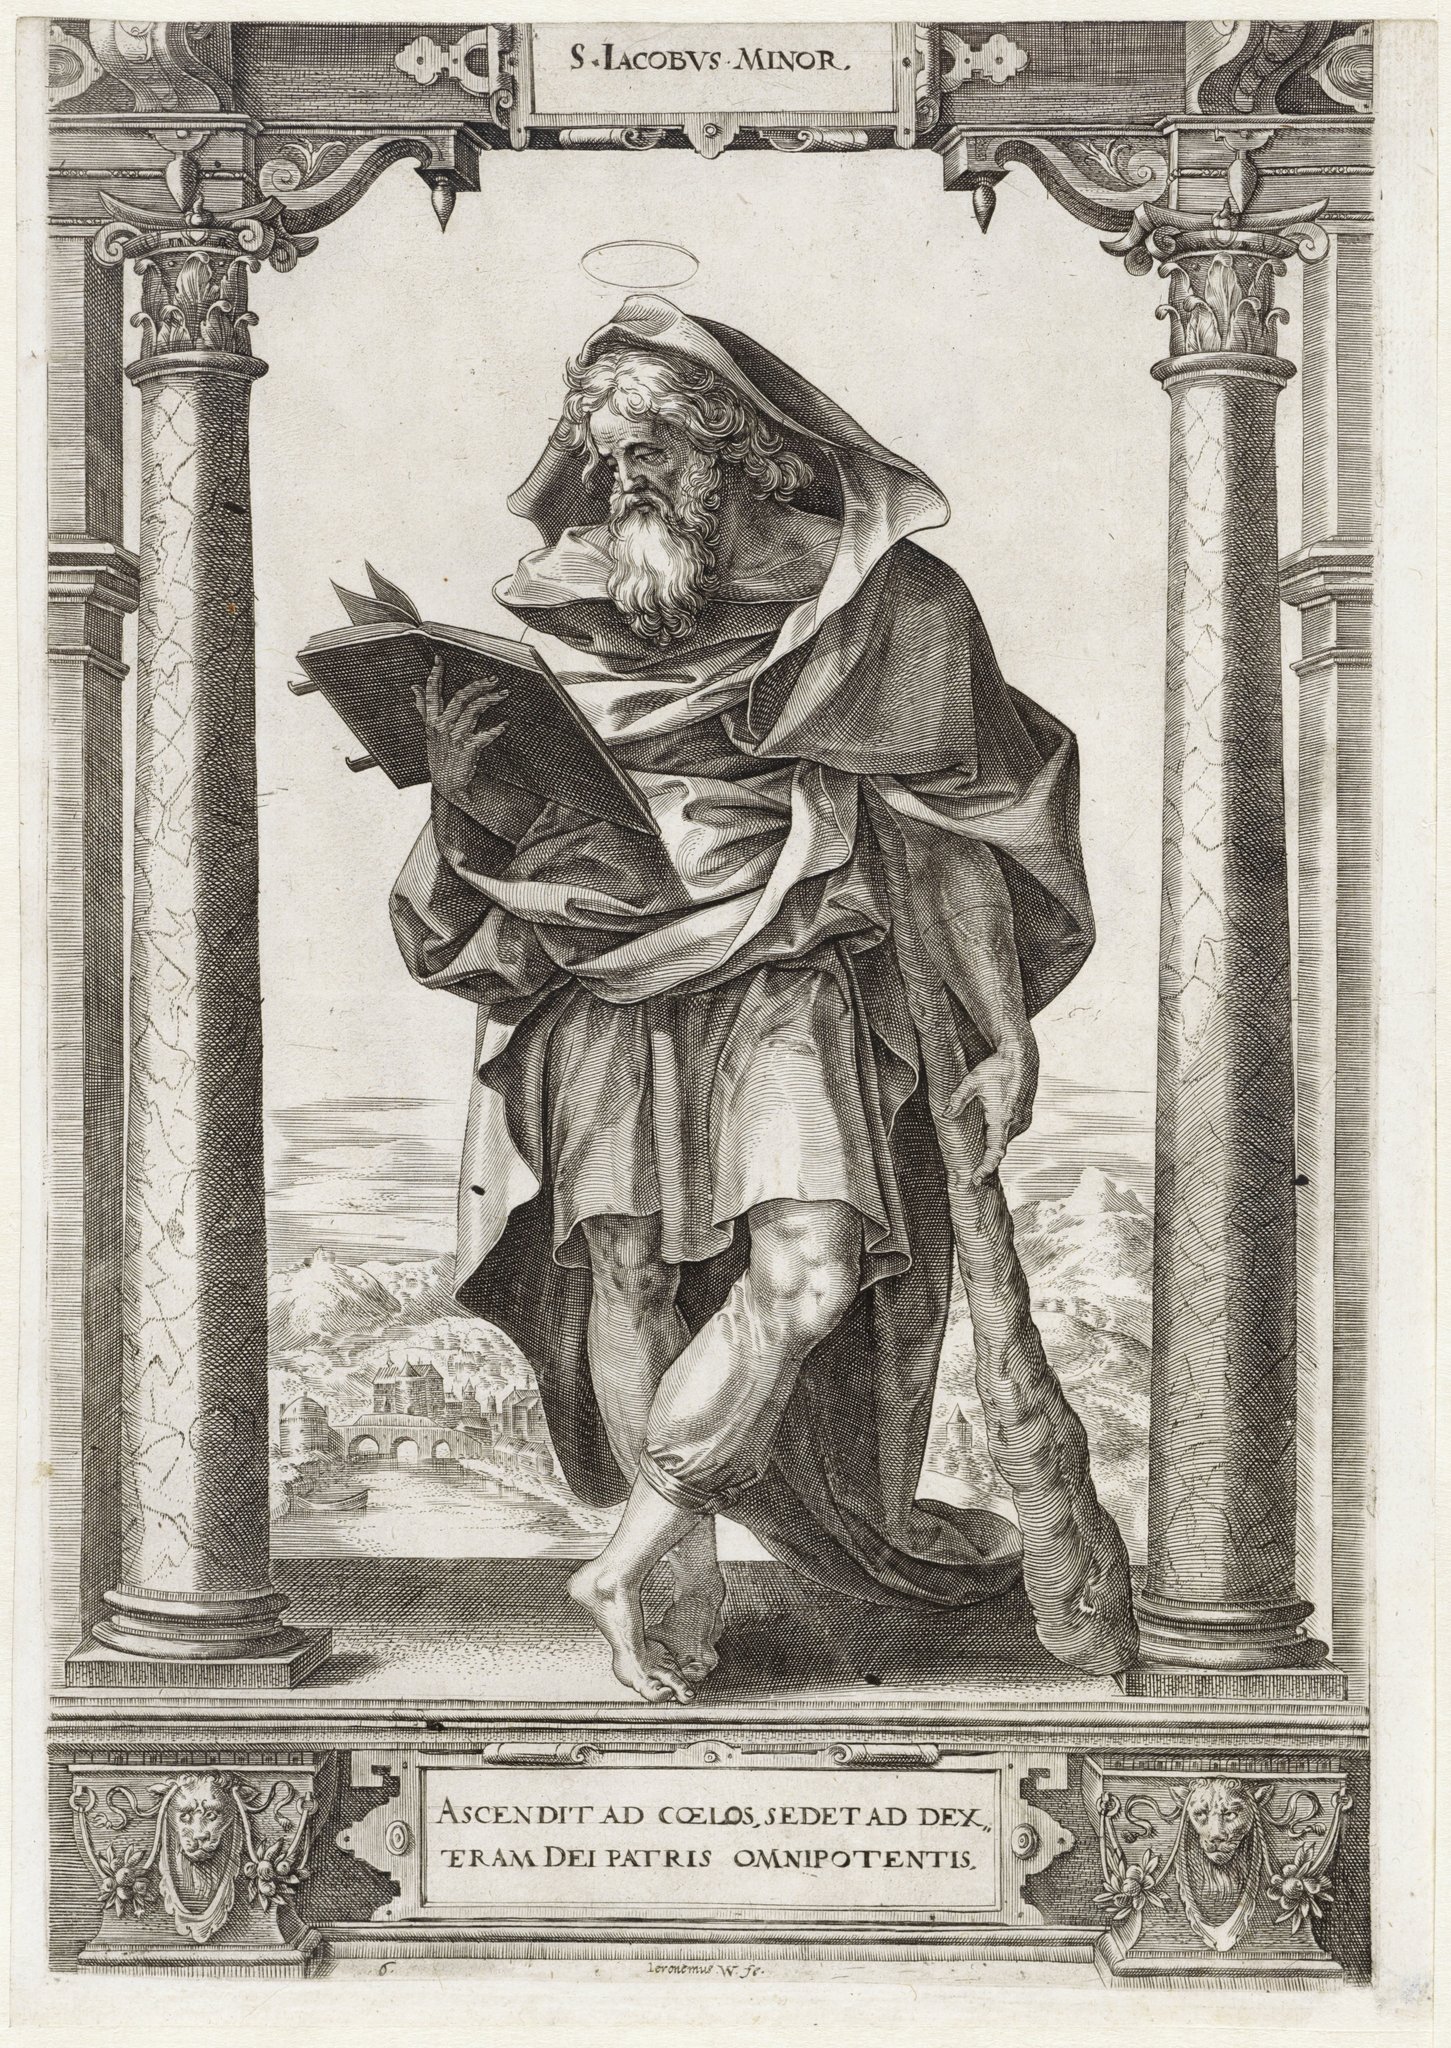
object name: print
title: Christus en de twaalf apostelen, en H. Paulus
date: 1578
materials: paper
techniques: engraving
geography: antwerp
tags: column, pillar ~ architecture, the apostle james the less, first bishop of jerusalem; possible attributes: book, fuller's club, scroll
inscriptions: collector's mark: Lugt 2228, collector's mark: Lugt 2760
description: De heilige Jakobus de Mindere staat tussen twee zuilen in een architecturale omlijsting. Hij leest in een boek dat hij in zijn hand houdt. Met zijn andere hand leunt hij tegen een voldersknuppel. Op de achtergrond een gezicht op een heuvelachtig landschap. In het kader onderaan een tweeregelig onderschrift in het Latijn.